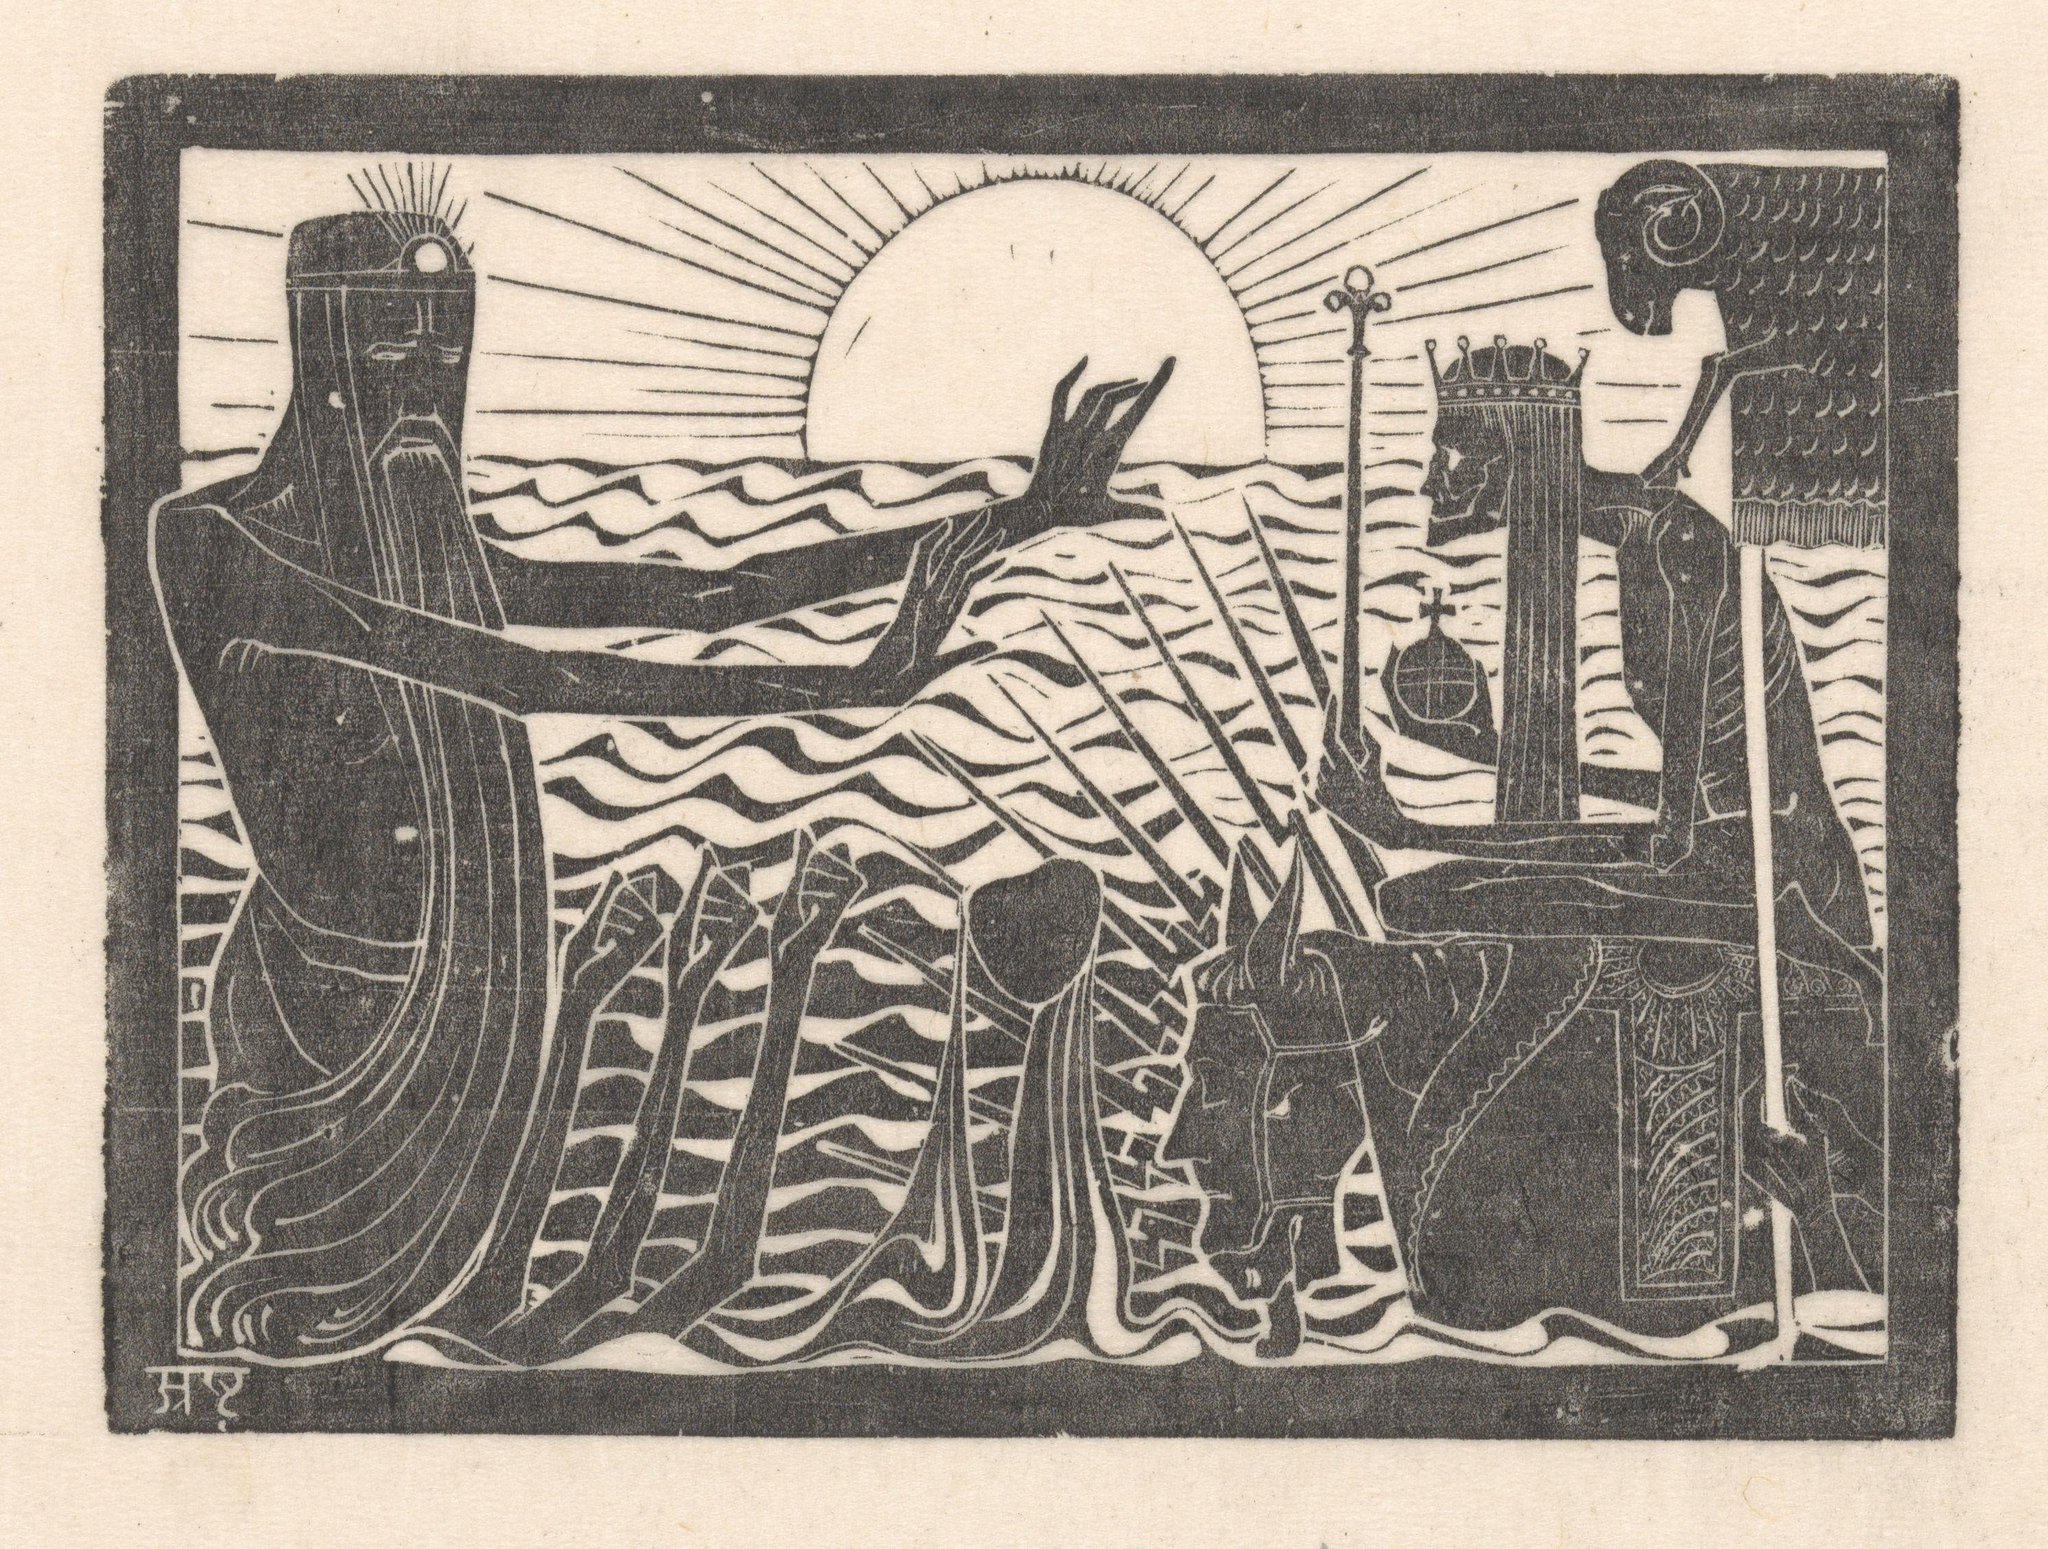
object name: print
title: Poseidon en een vorst op een boot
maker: karel petrus cornelis de bazel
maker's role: draughtsman, print maker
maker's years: 1869-1923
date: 1894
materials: paper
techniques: woodcut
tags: (story of) neptune (poseidon), arm raised, with fist, ram, parts of ship's exterior: figure-head, insignia and symbols of sovereignty (crown, diadem, sceptre, orb, seal, standard, cloak, pectoral)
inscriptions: collector's mark: Lugt 2228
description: Een man met lang haar en een lange baard staat in zee. Rechts naast hem steken drie armen met gebalde vuisten uit het water. De man strekt zijn armen uit naar een magere figuur op een boot, die een scepter, kroon en rijksappel draagt. Rechts van deze figuur wordt de beeltenis van een ram in de lucht gestoken. Aan de boot hangt een boegbeeld van een man met een gehoornd hoofd. Op de achtergrond raakt de zon de zee aan de horizon.